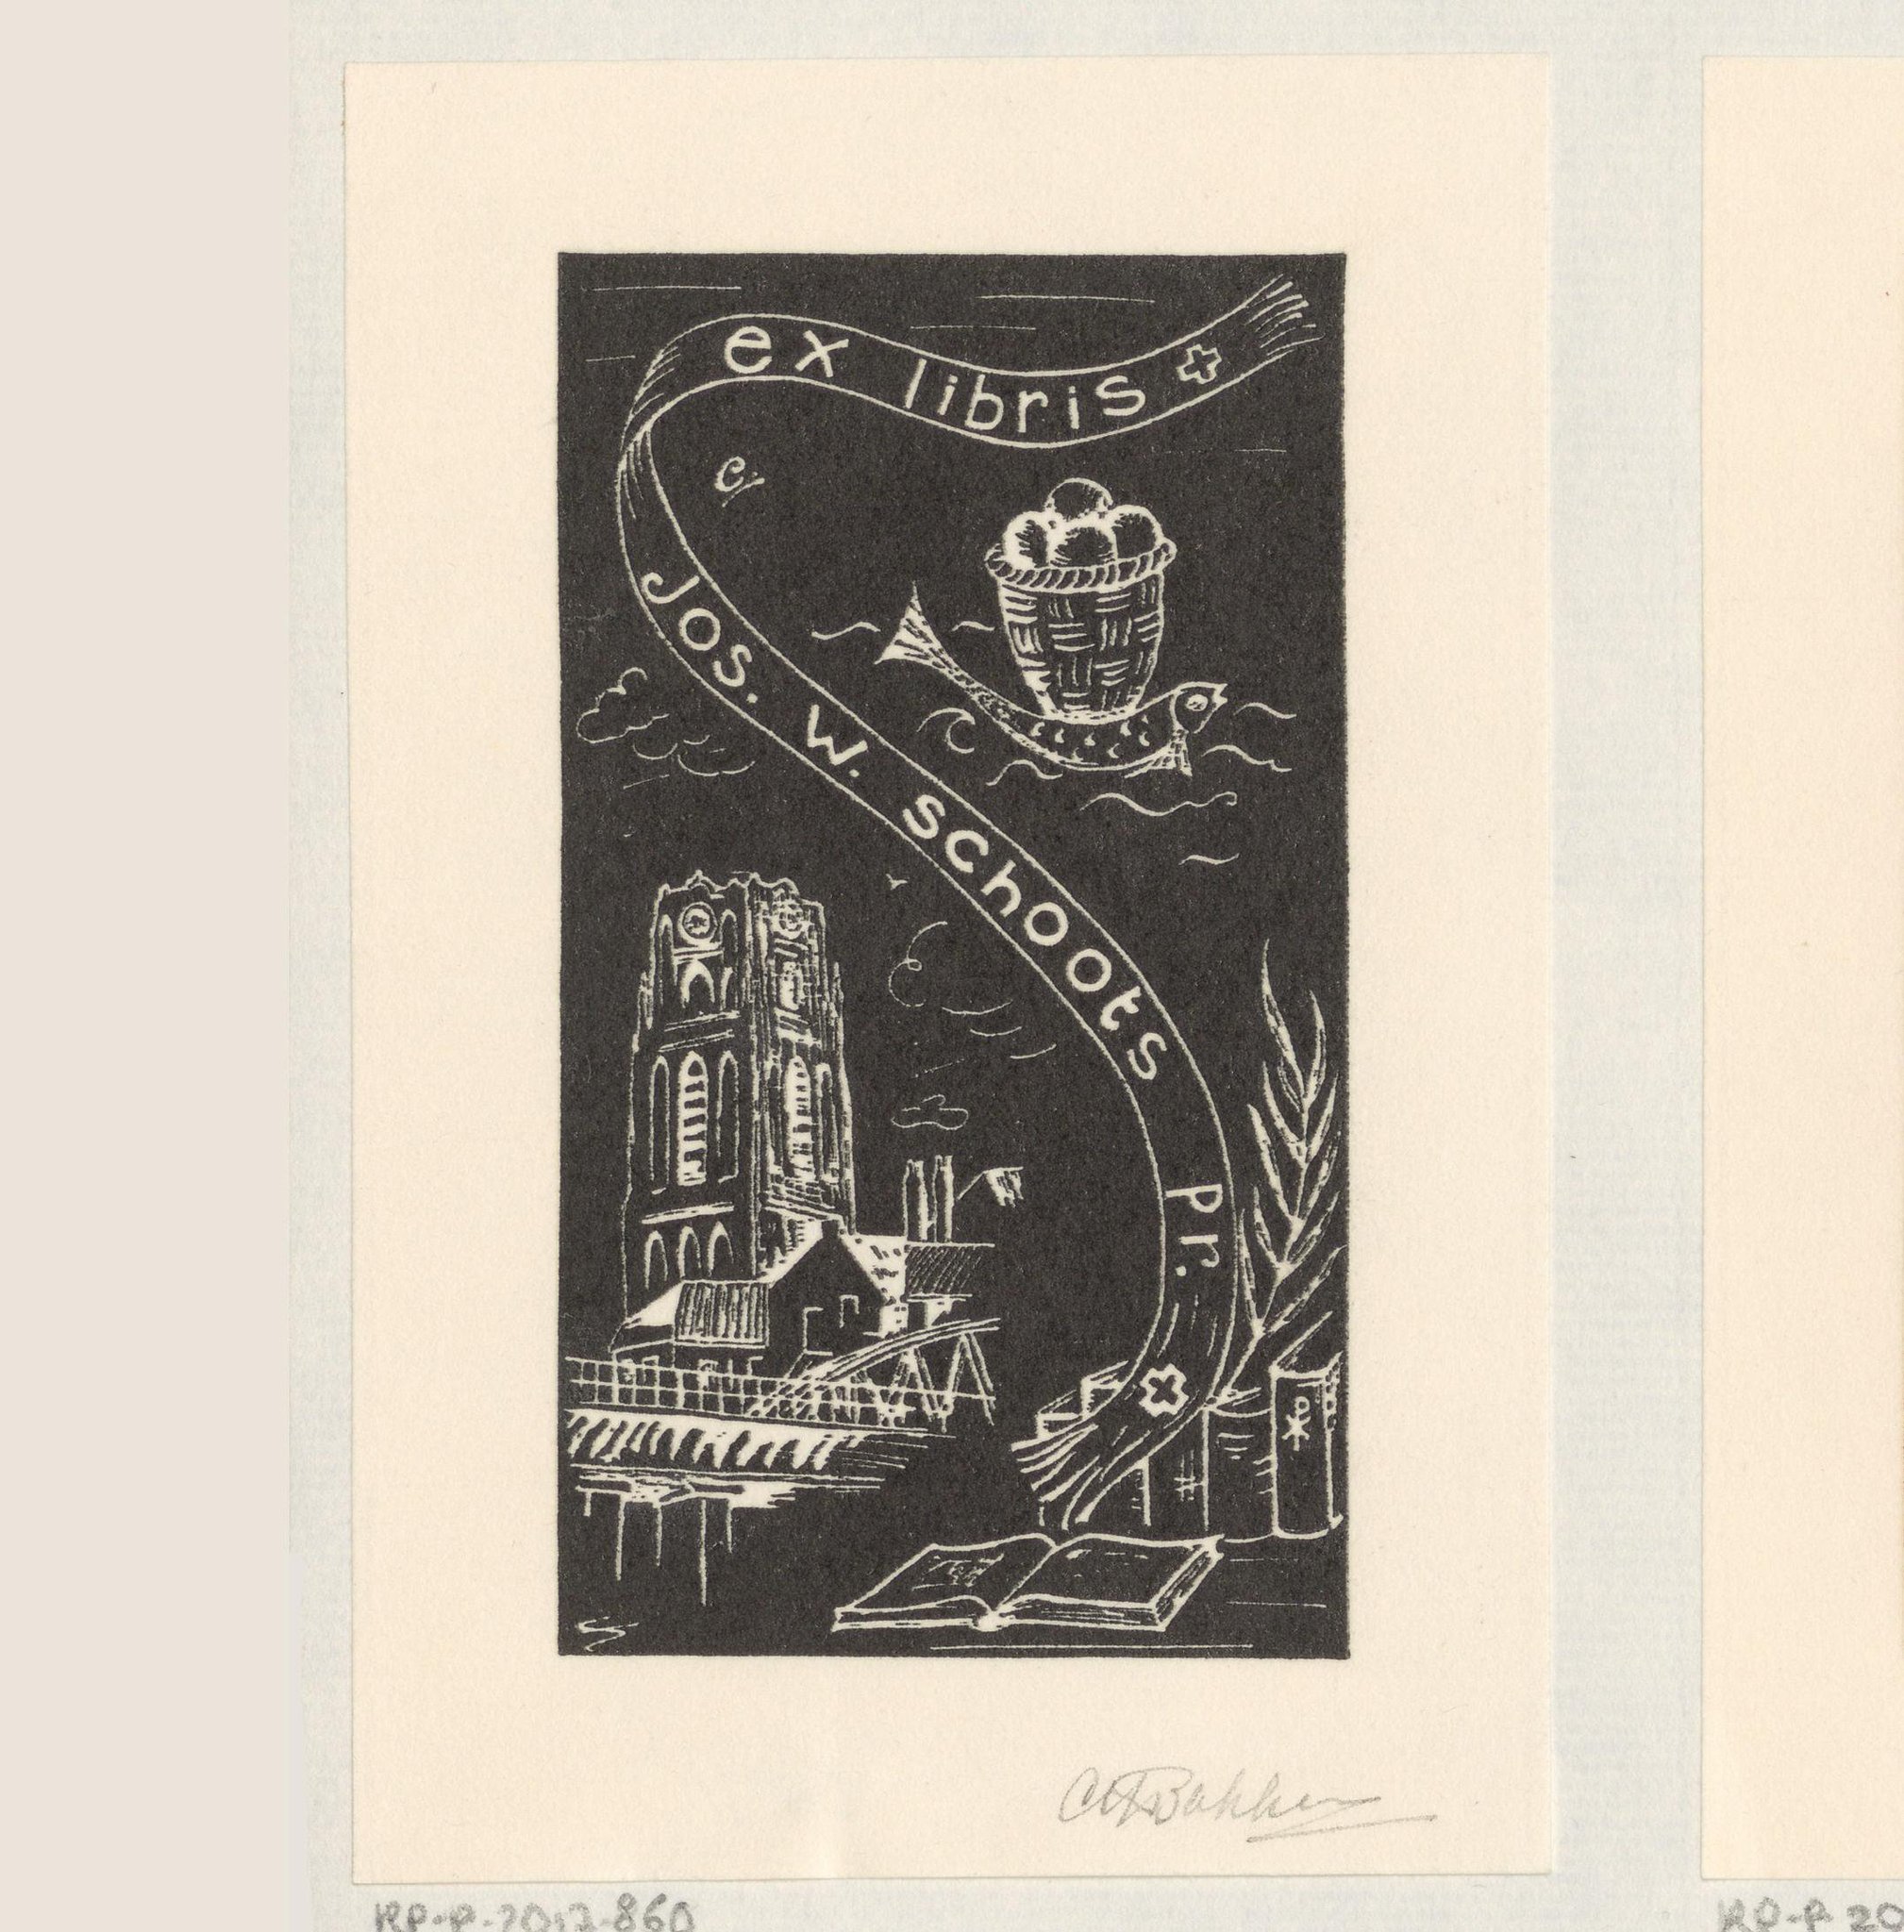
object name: bookplate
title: Ex libris van Jos. W. Schoots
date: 1900-1999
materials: paper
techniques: printing block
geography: netherlands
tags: book, parts of church exterior and annexes, christian religion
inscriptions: signature: ‘C (?) Bakker’